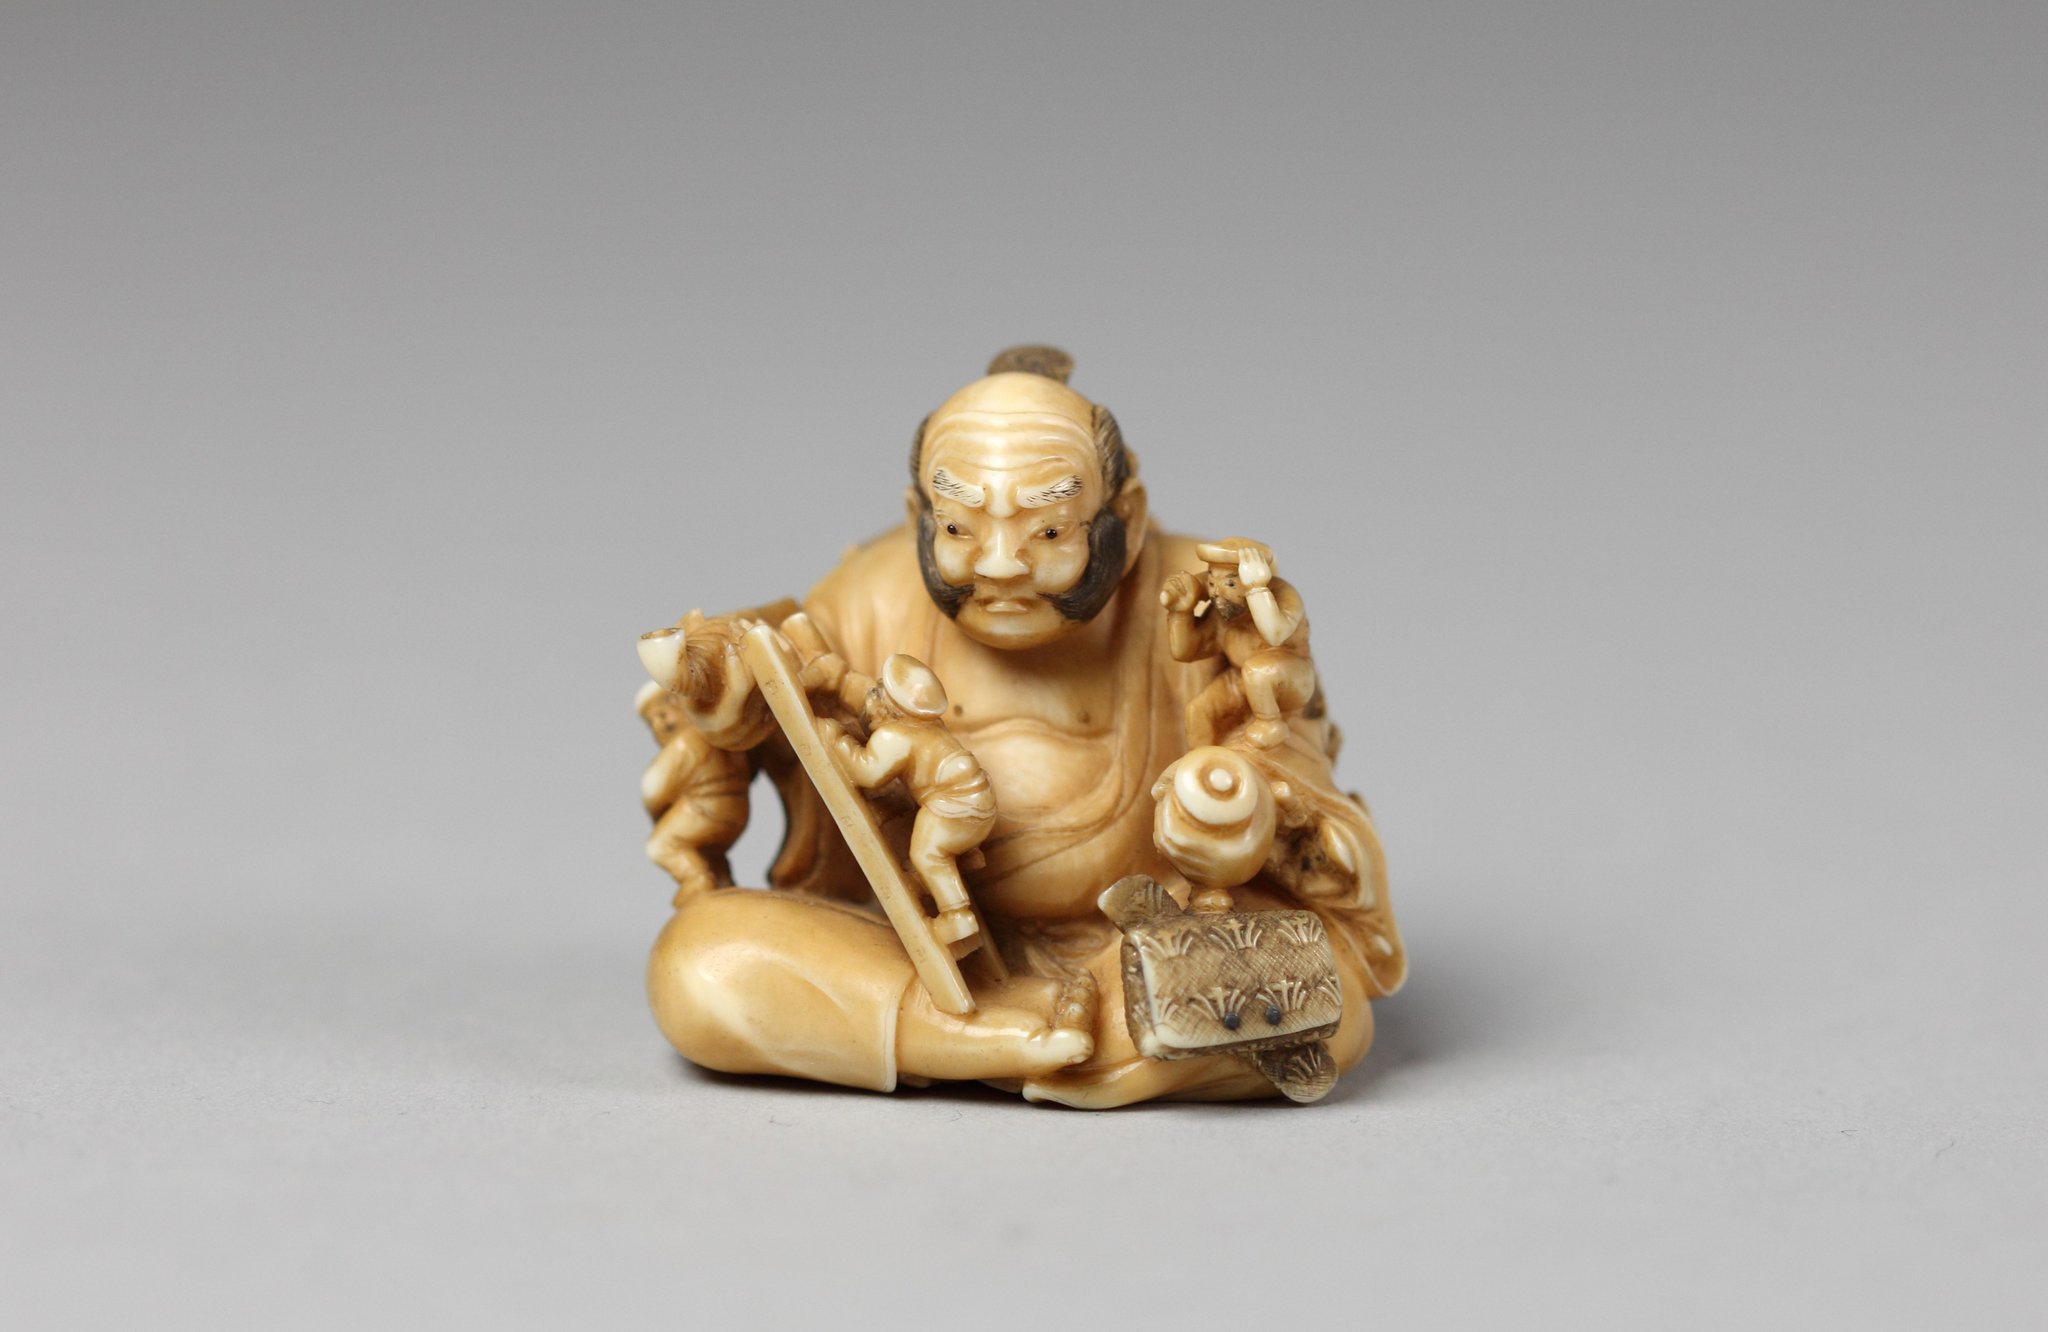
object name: netsuke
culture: japanese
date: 1801-1900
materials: ivory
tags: men,ladders